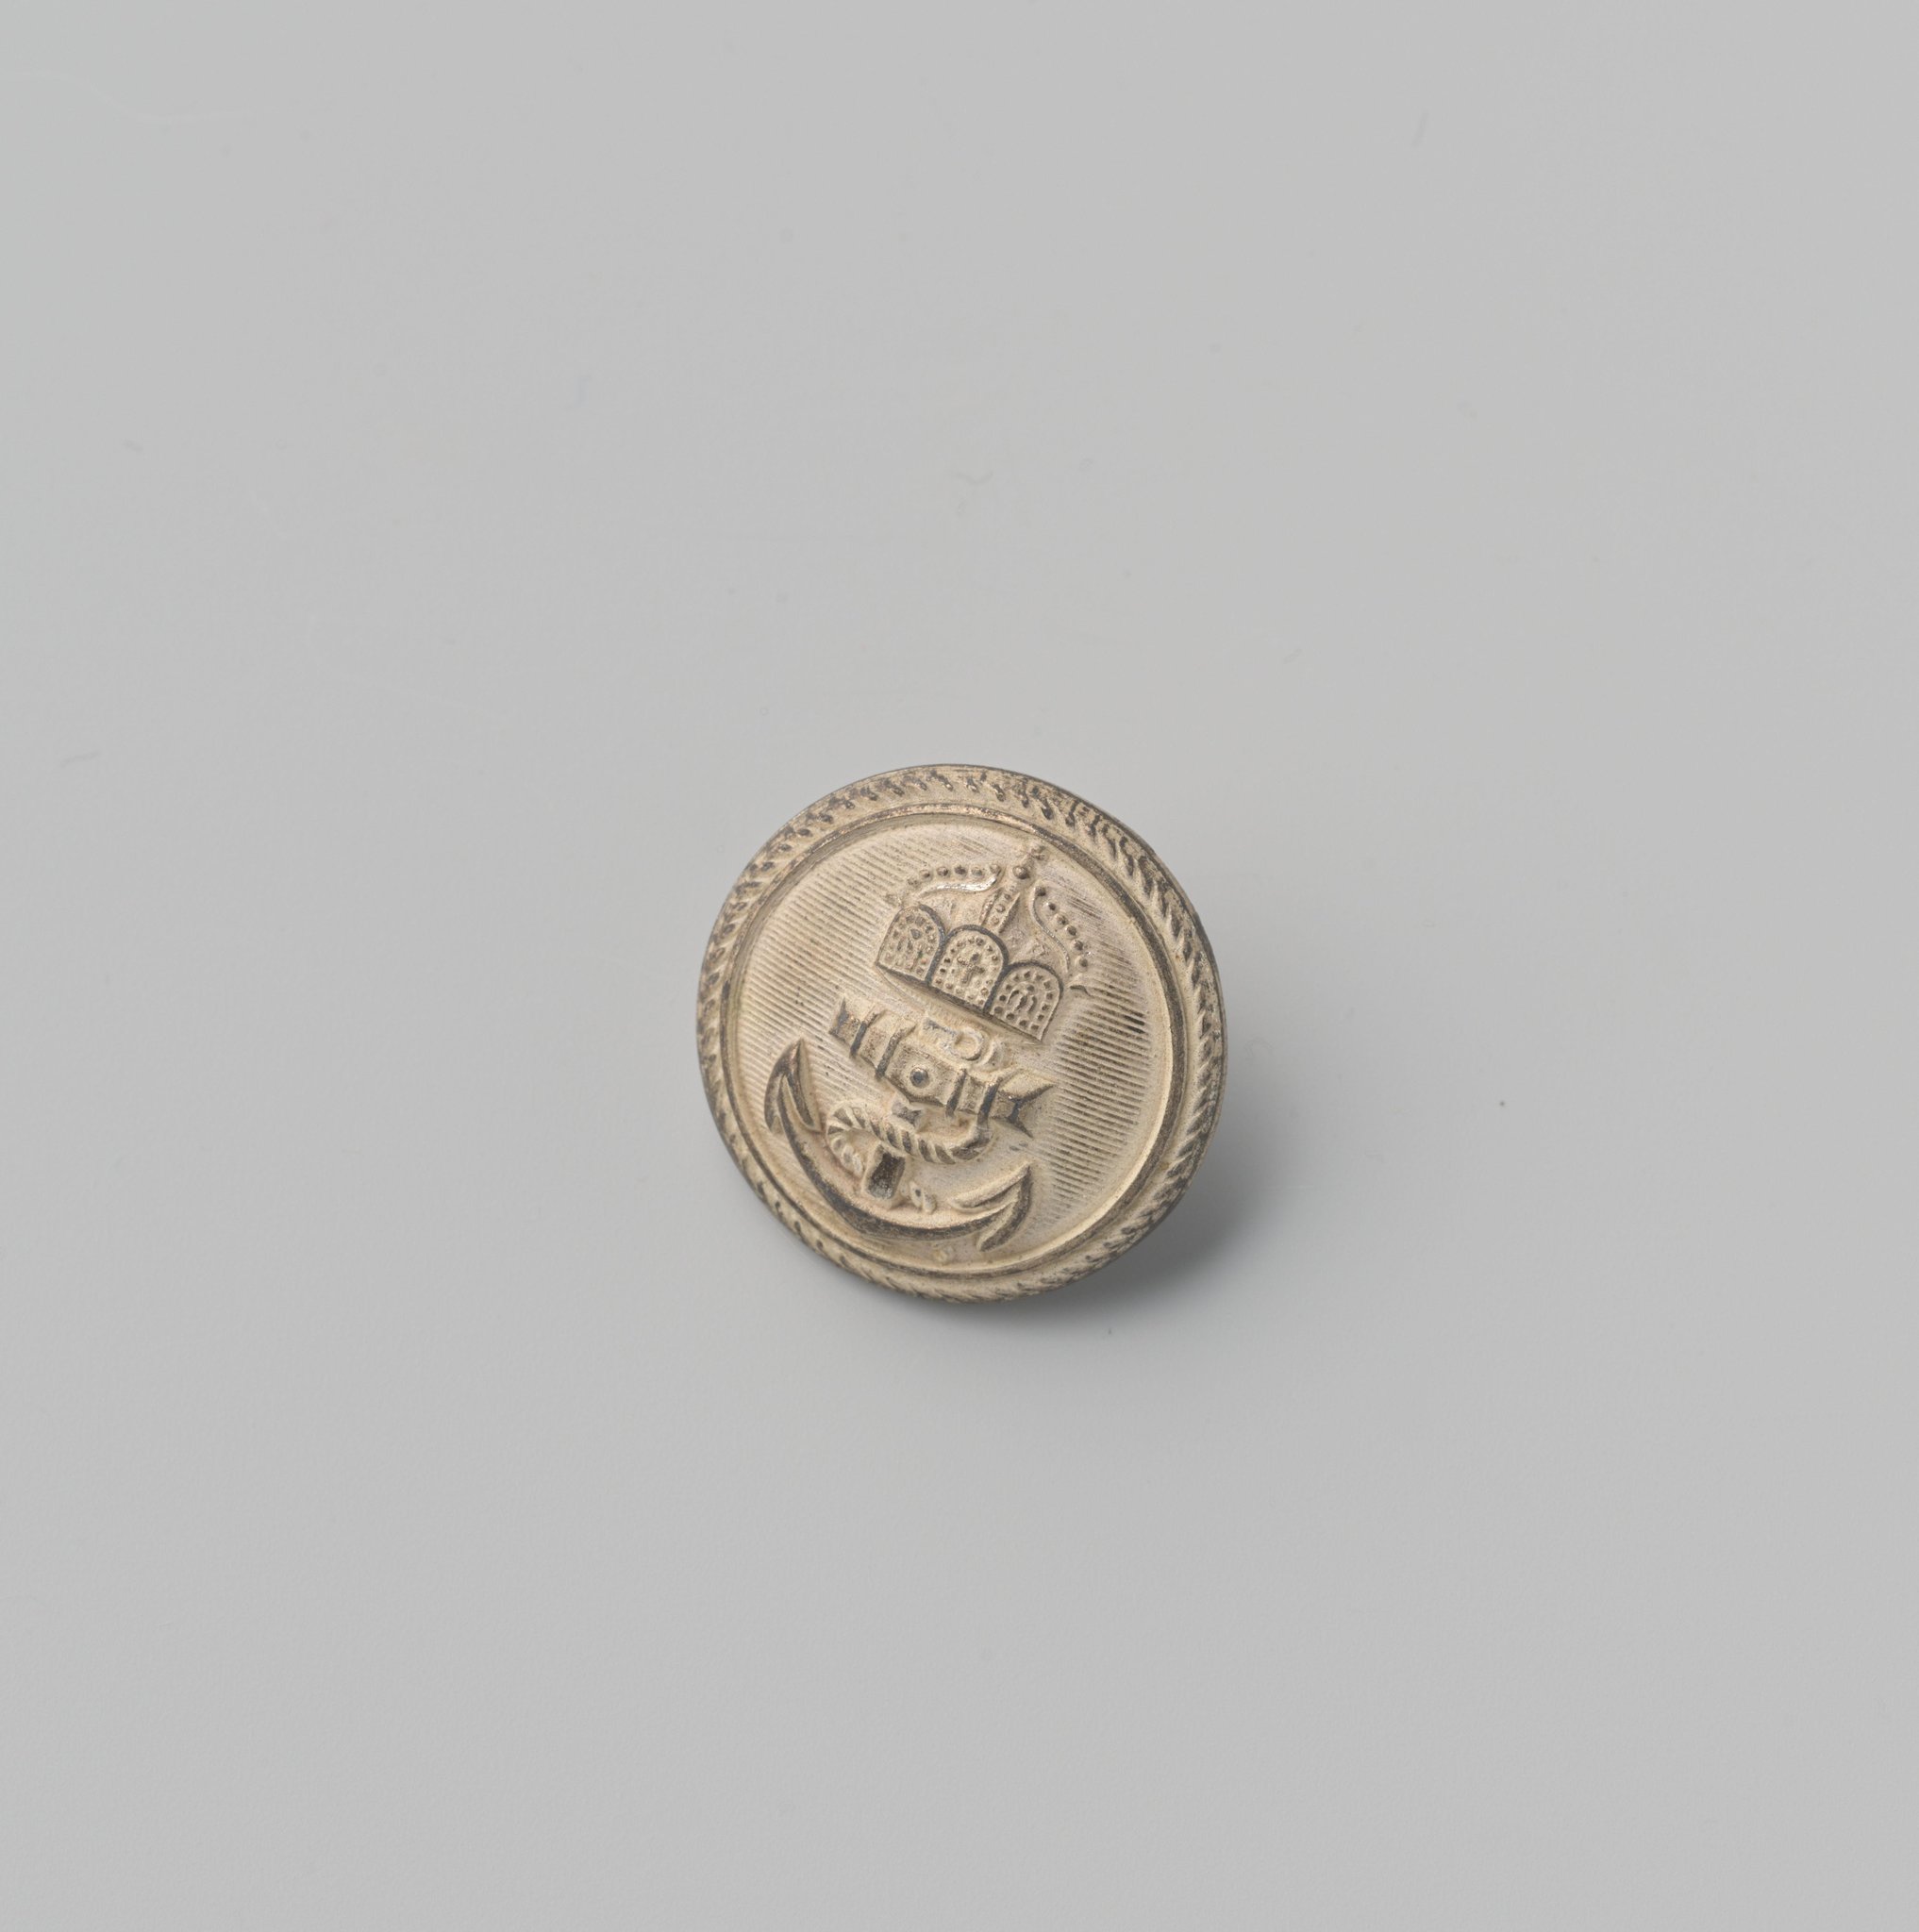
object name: button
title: Knoop van de Duitse keizerlijke marine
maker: Anonymous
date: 1900-1925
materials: metal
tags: eugen wachenheimer, else wachenheimer-moos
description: Dit object is onderdeel van de nalatenschap van Isabel Elon-Wachenheimer (1928-2010). Tot haar overlijden behoorde het samen met de andere objecten uit de nalatenschap tot haar privédomein van Isabel Wachenheimer. In die particuliere context zijn deze objecten tezamen en individueel aandenkens - aan de jeugd, ouders en familie van Isabel Wachenheimer vóór en tijdens de Shoah en aan haar leven na de Tweede Wereldoorlog. Isabel Wachenheimer, die van juni 1943 tot mei 1945 gevangen zat in Kamp Westerbork, Theresienstadt, Auschwitz, Lenzing a/d Oberdonau (een buitenkamp van Mauthausen), overleefde de Shoah. Haar ouders – Eugène Wachenheimer en Else Wachenheimer-Moos - werden op 14 oktober 1944 in Auschwitz-Birkenau vermoord.